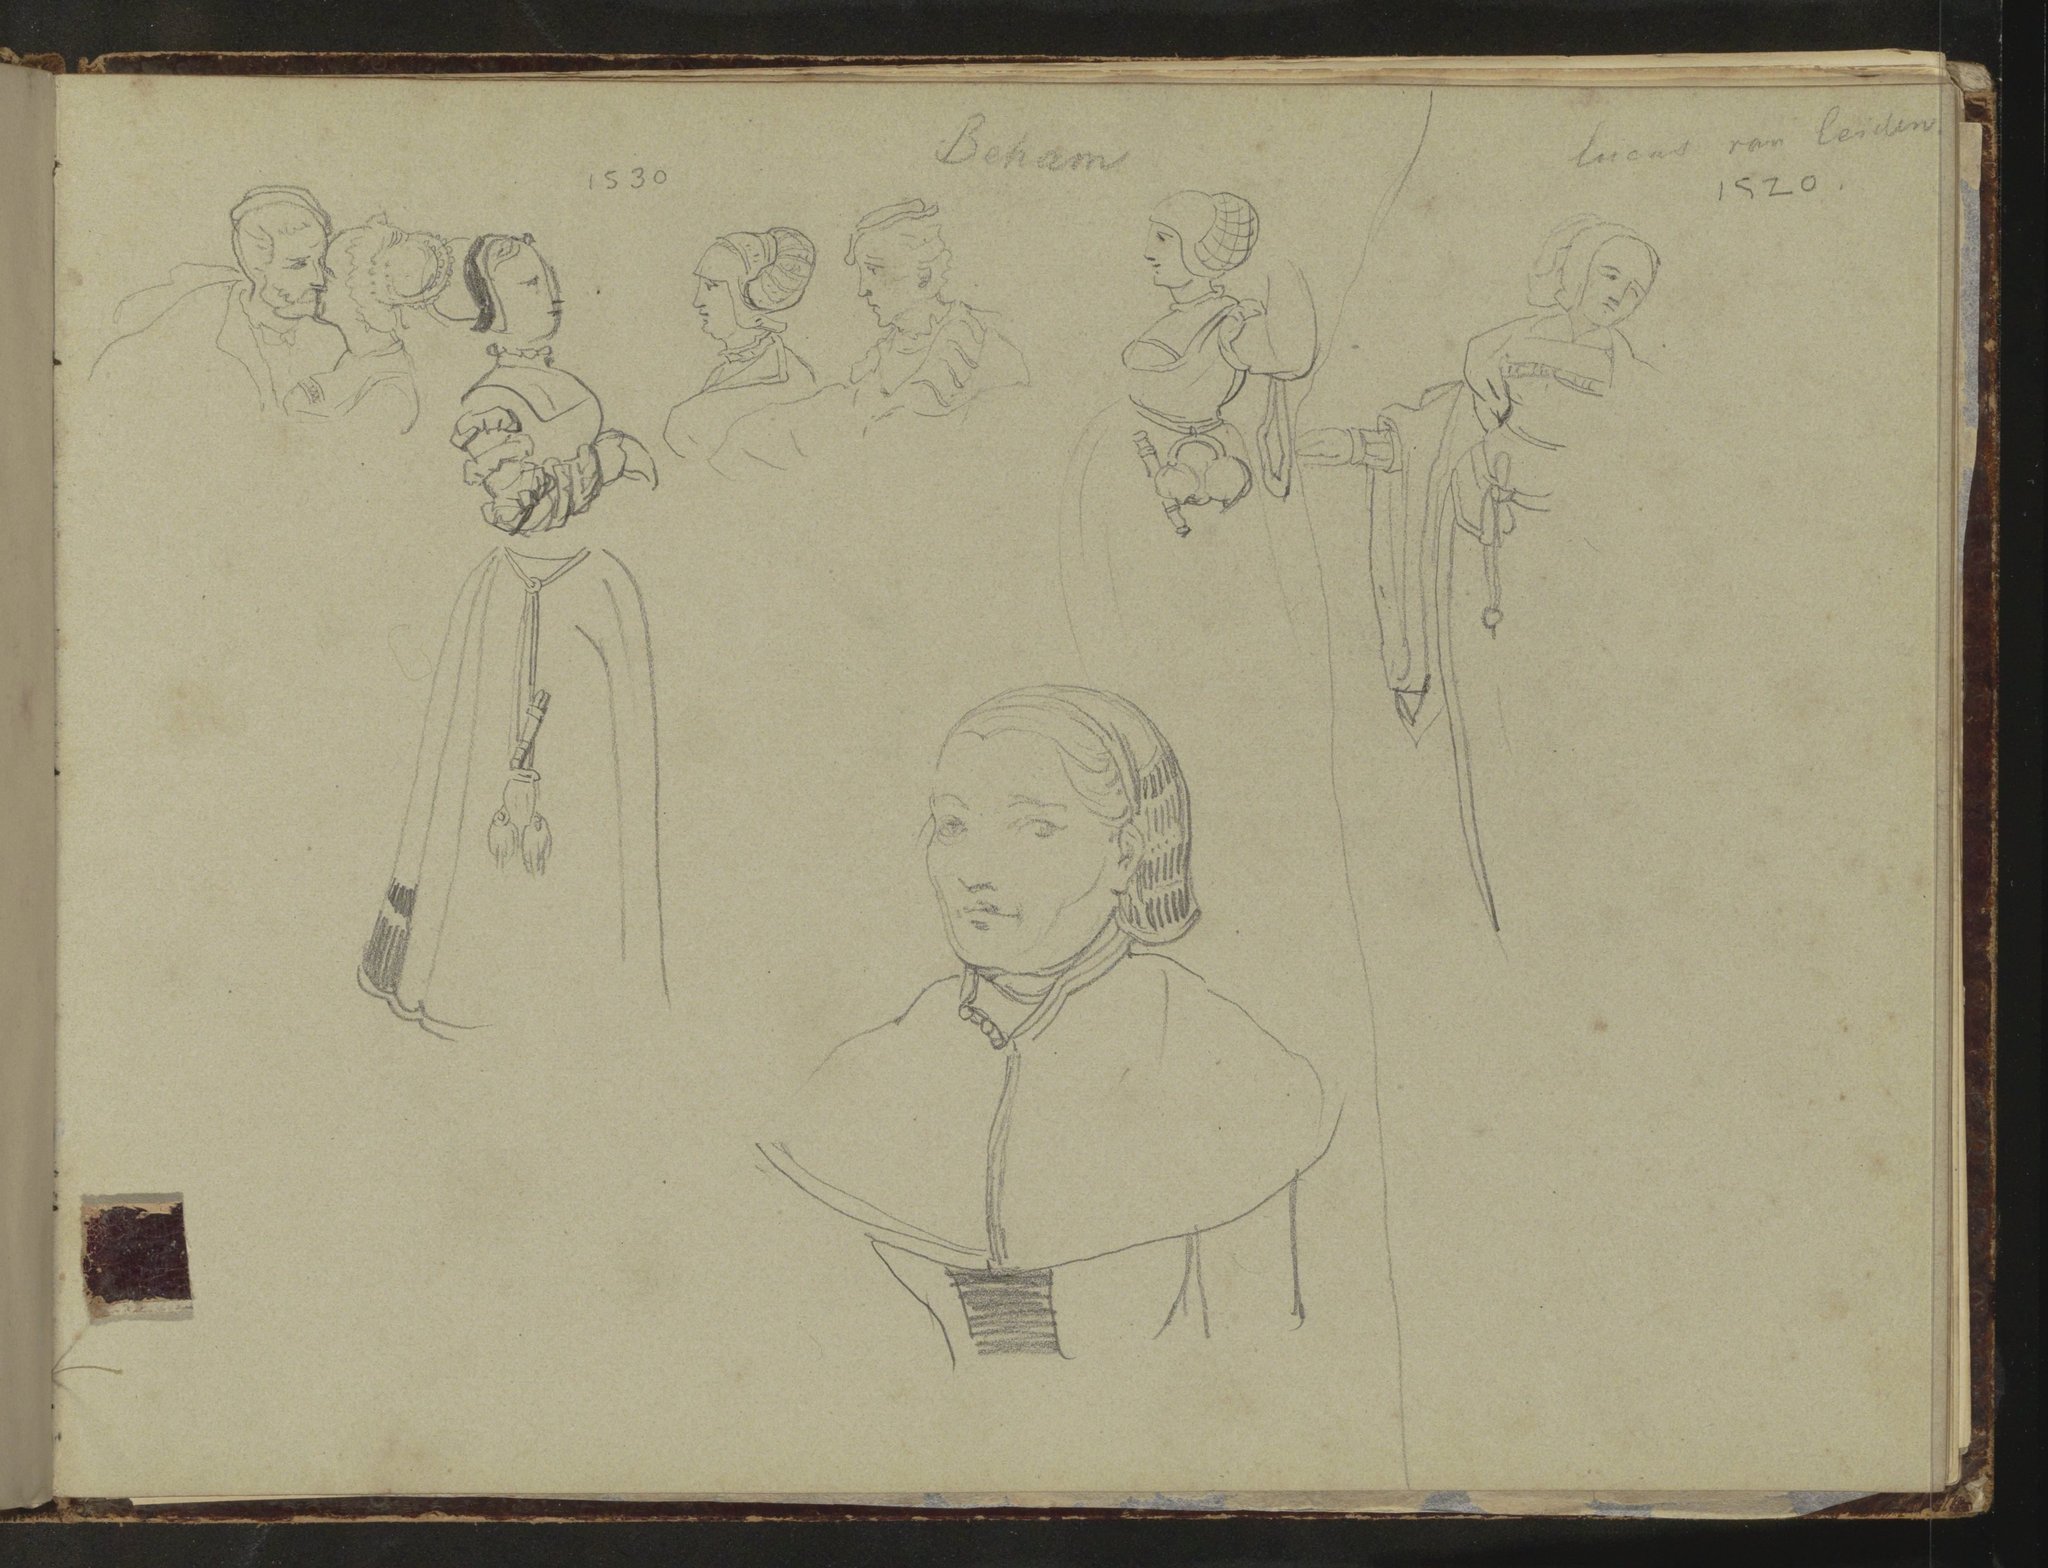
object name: sketchbook leaf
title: Mannen en vrouwen in zestiende-eeuwse dracht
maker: reinier craeyvanger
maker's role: draughtsman, print maker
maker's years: 1812-1880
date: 1822-1880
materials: paper, pencil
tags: head (human), standing figure - aa - female human figure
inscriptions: annotation: ‘1530 Beham/ Lucas van Leiden/ 1520.’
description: Blad 26 recto uit een schetsboek met 45 bladen.